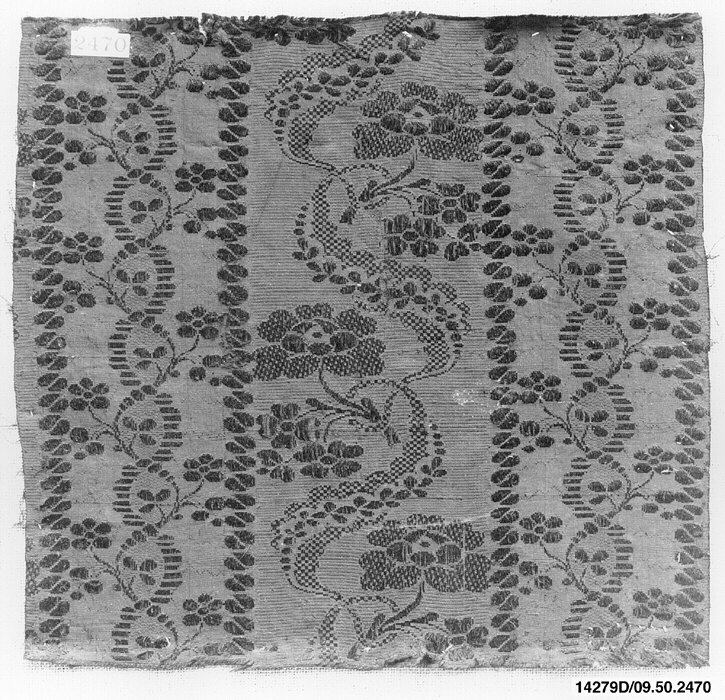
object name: piece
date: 1801-1900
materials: silk